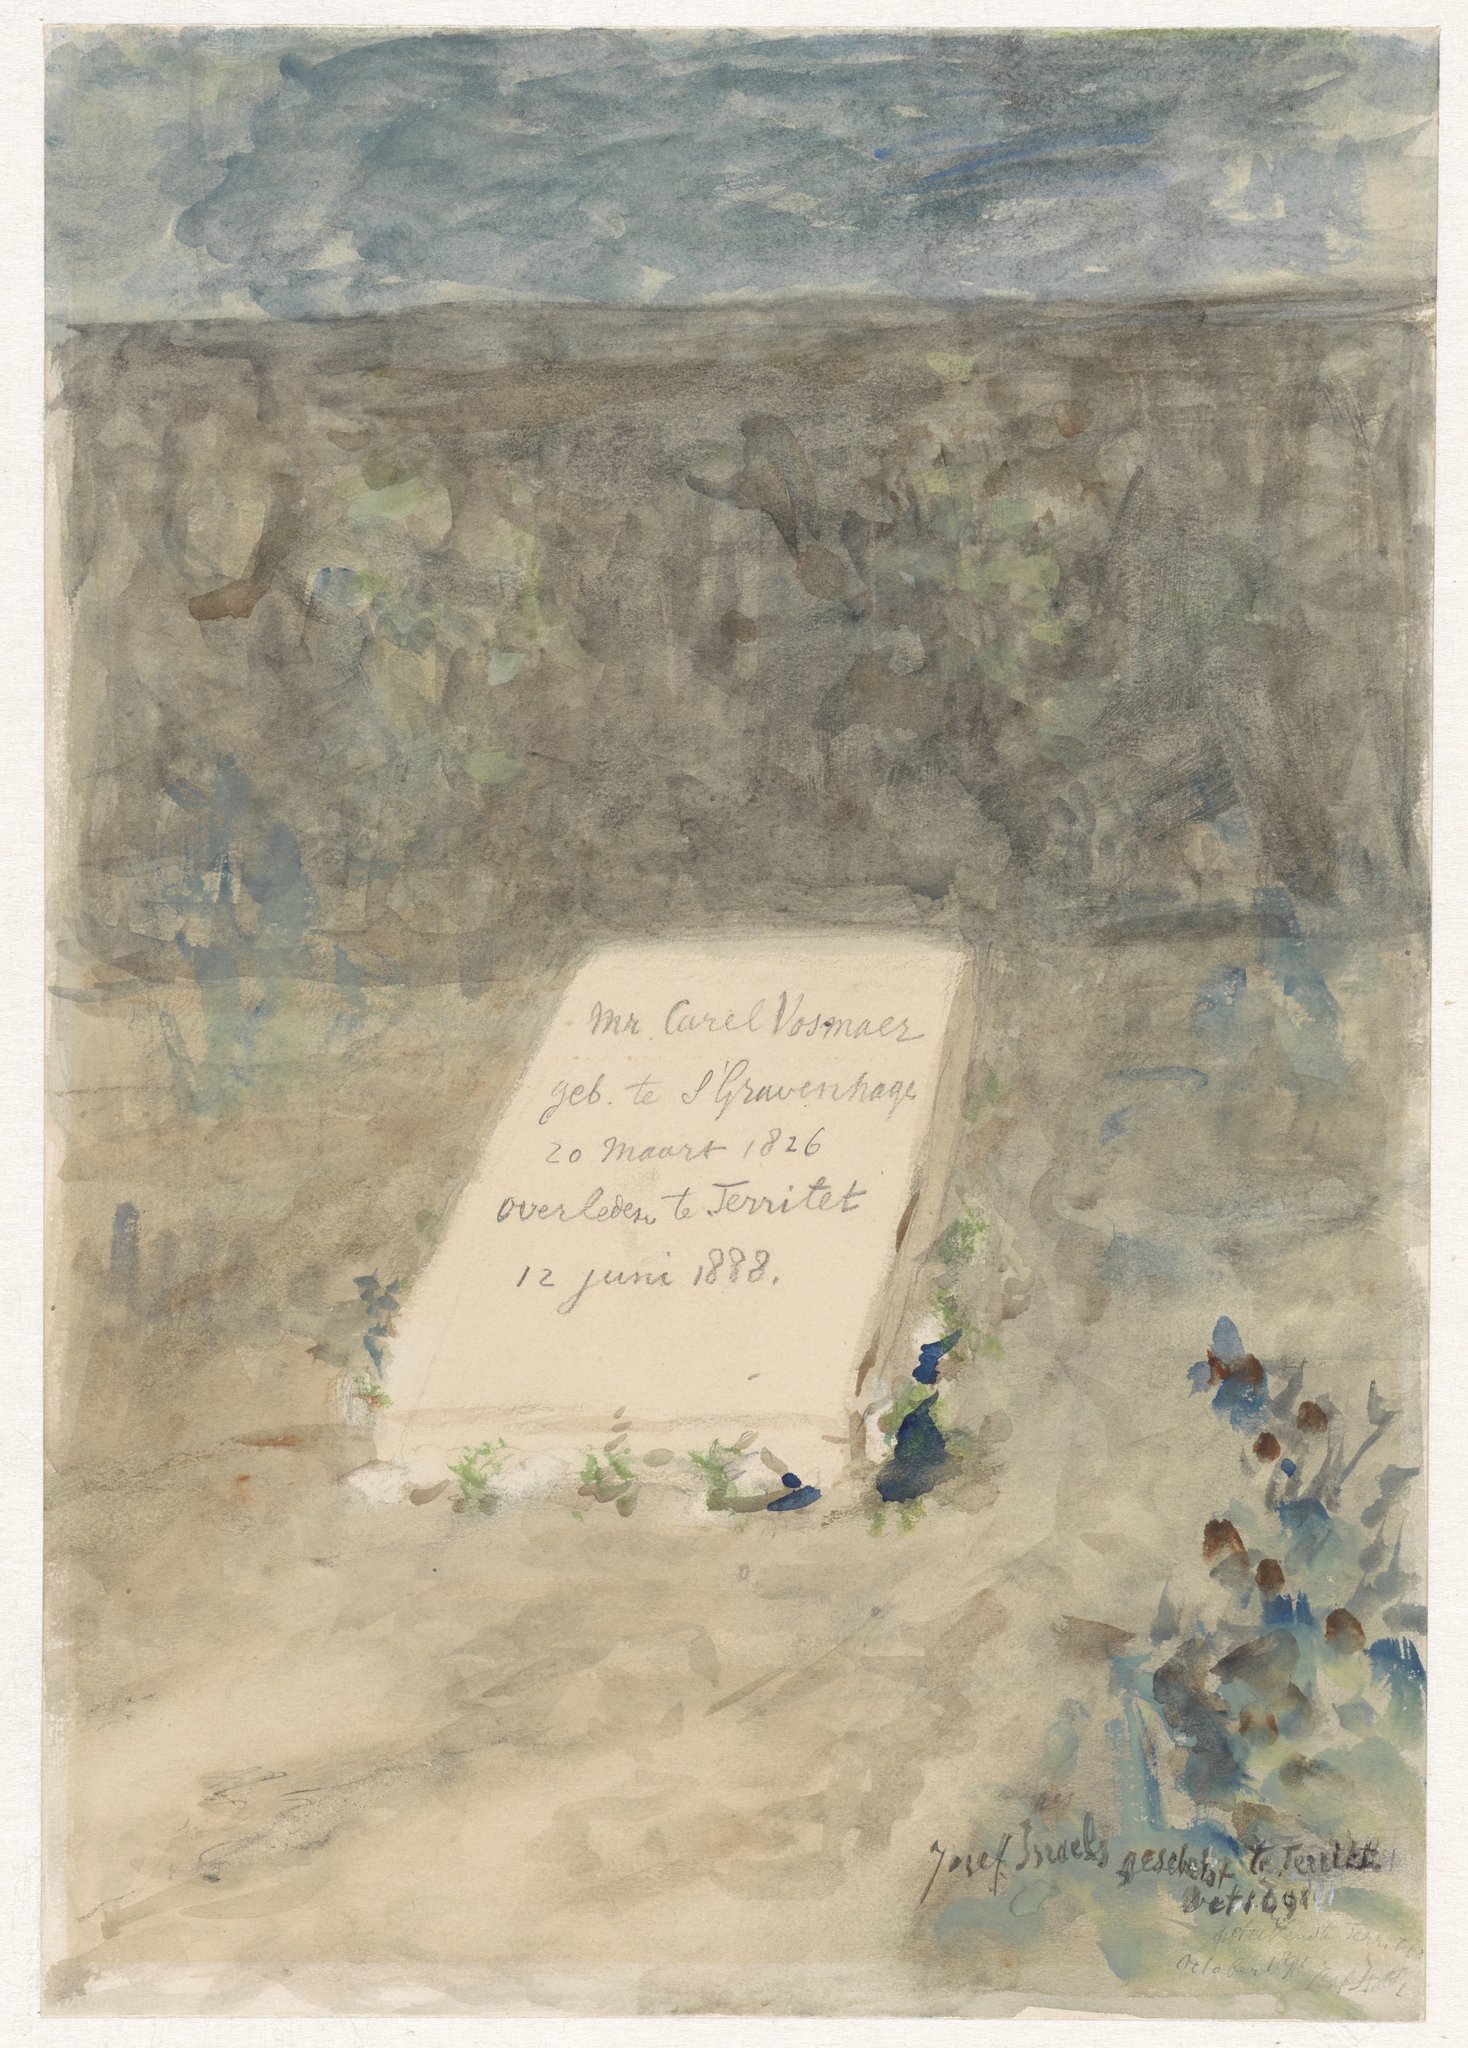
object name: watercolor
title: Graf van Mr. Carel Vosmaer te Territet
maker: jozef israëls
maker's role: draughtsman, painter, print maker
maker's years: 1824-1911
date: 1810-1891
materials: paper, pencil, watercolor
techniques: brush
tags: carel vosmaer, historical persons, gravestone, tombstone